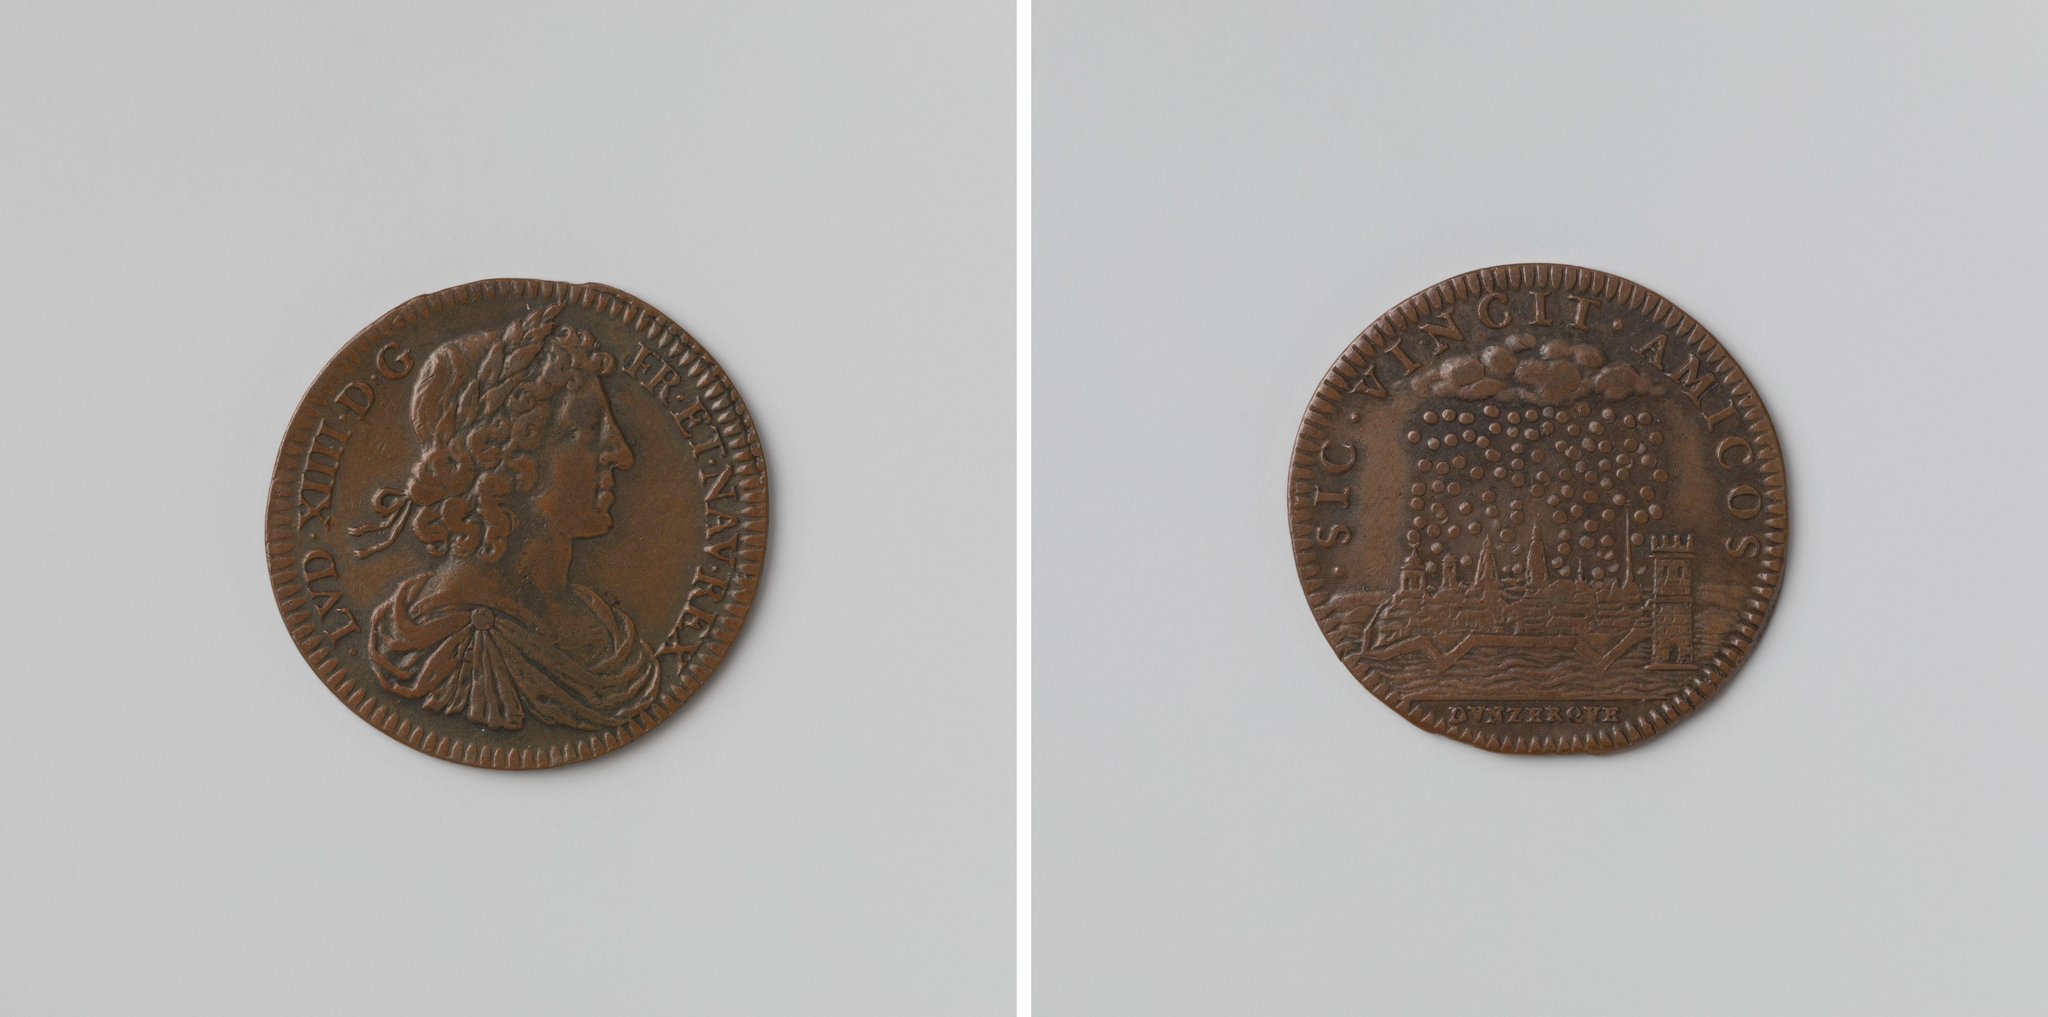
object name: jeton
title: Duinkerken door de Fransen van Engeland gekocht, rekenpenning geslagen ter ere van Lodewijk XIV, koning van Frankrijk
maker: Anonymous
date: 1662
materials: copper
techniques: striking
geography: france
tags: lodewijk xiv (koning van frankrijk)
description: Koperen penning. Voorzijde: borststuk man met lauwerkrans binnen omschrift. Keerzijde: uit wolken op stad Duinkerken neerdalende geldregen binnen omschrift; afsnede: opschrift